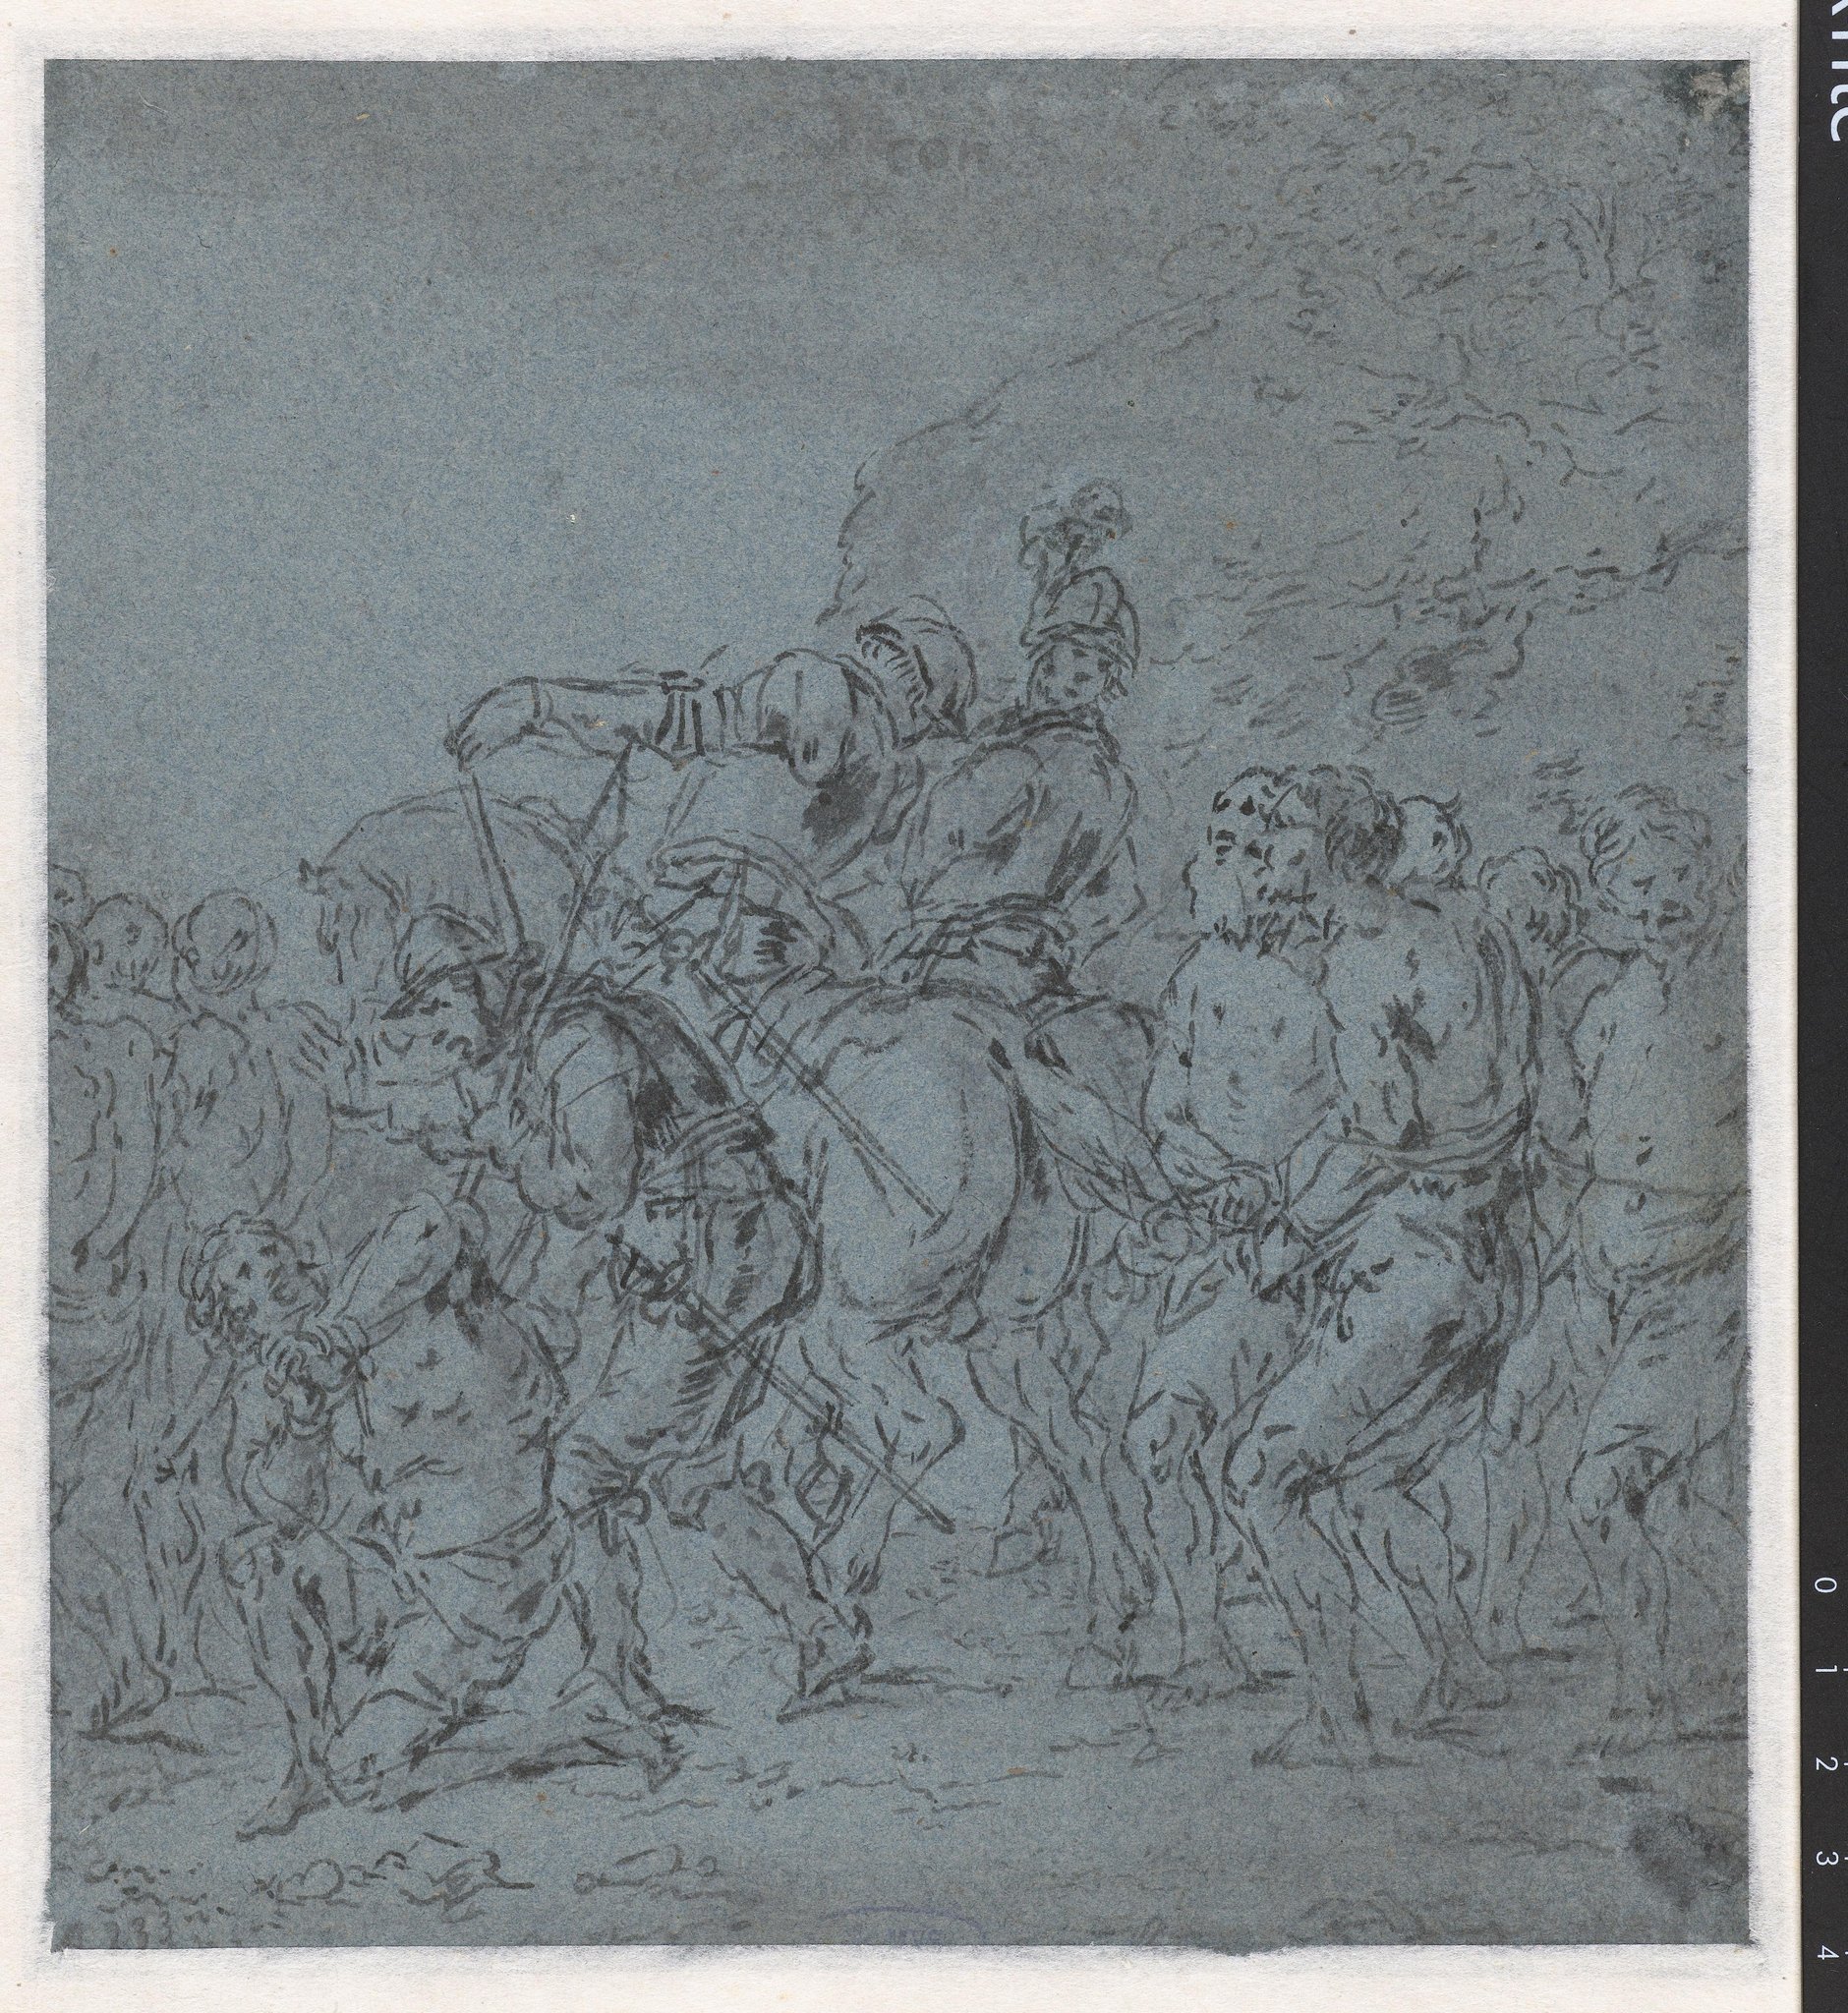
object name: drawing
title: Geboeide mannen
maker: leonaert bramer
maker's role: draughtsman, painter, print maker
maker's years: 1596-1674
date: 1606-1674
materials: ink, paper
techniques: brush, pen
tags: transfer, deportation ~ prisoner of war, prisoner with hands bound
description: Een transport krijgsgevangen mannen, van welke één door een soldaat wordt geslagen.